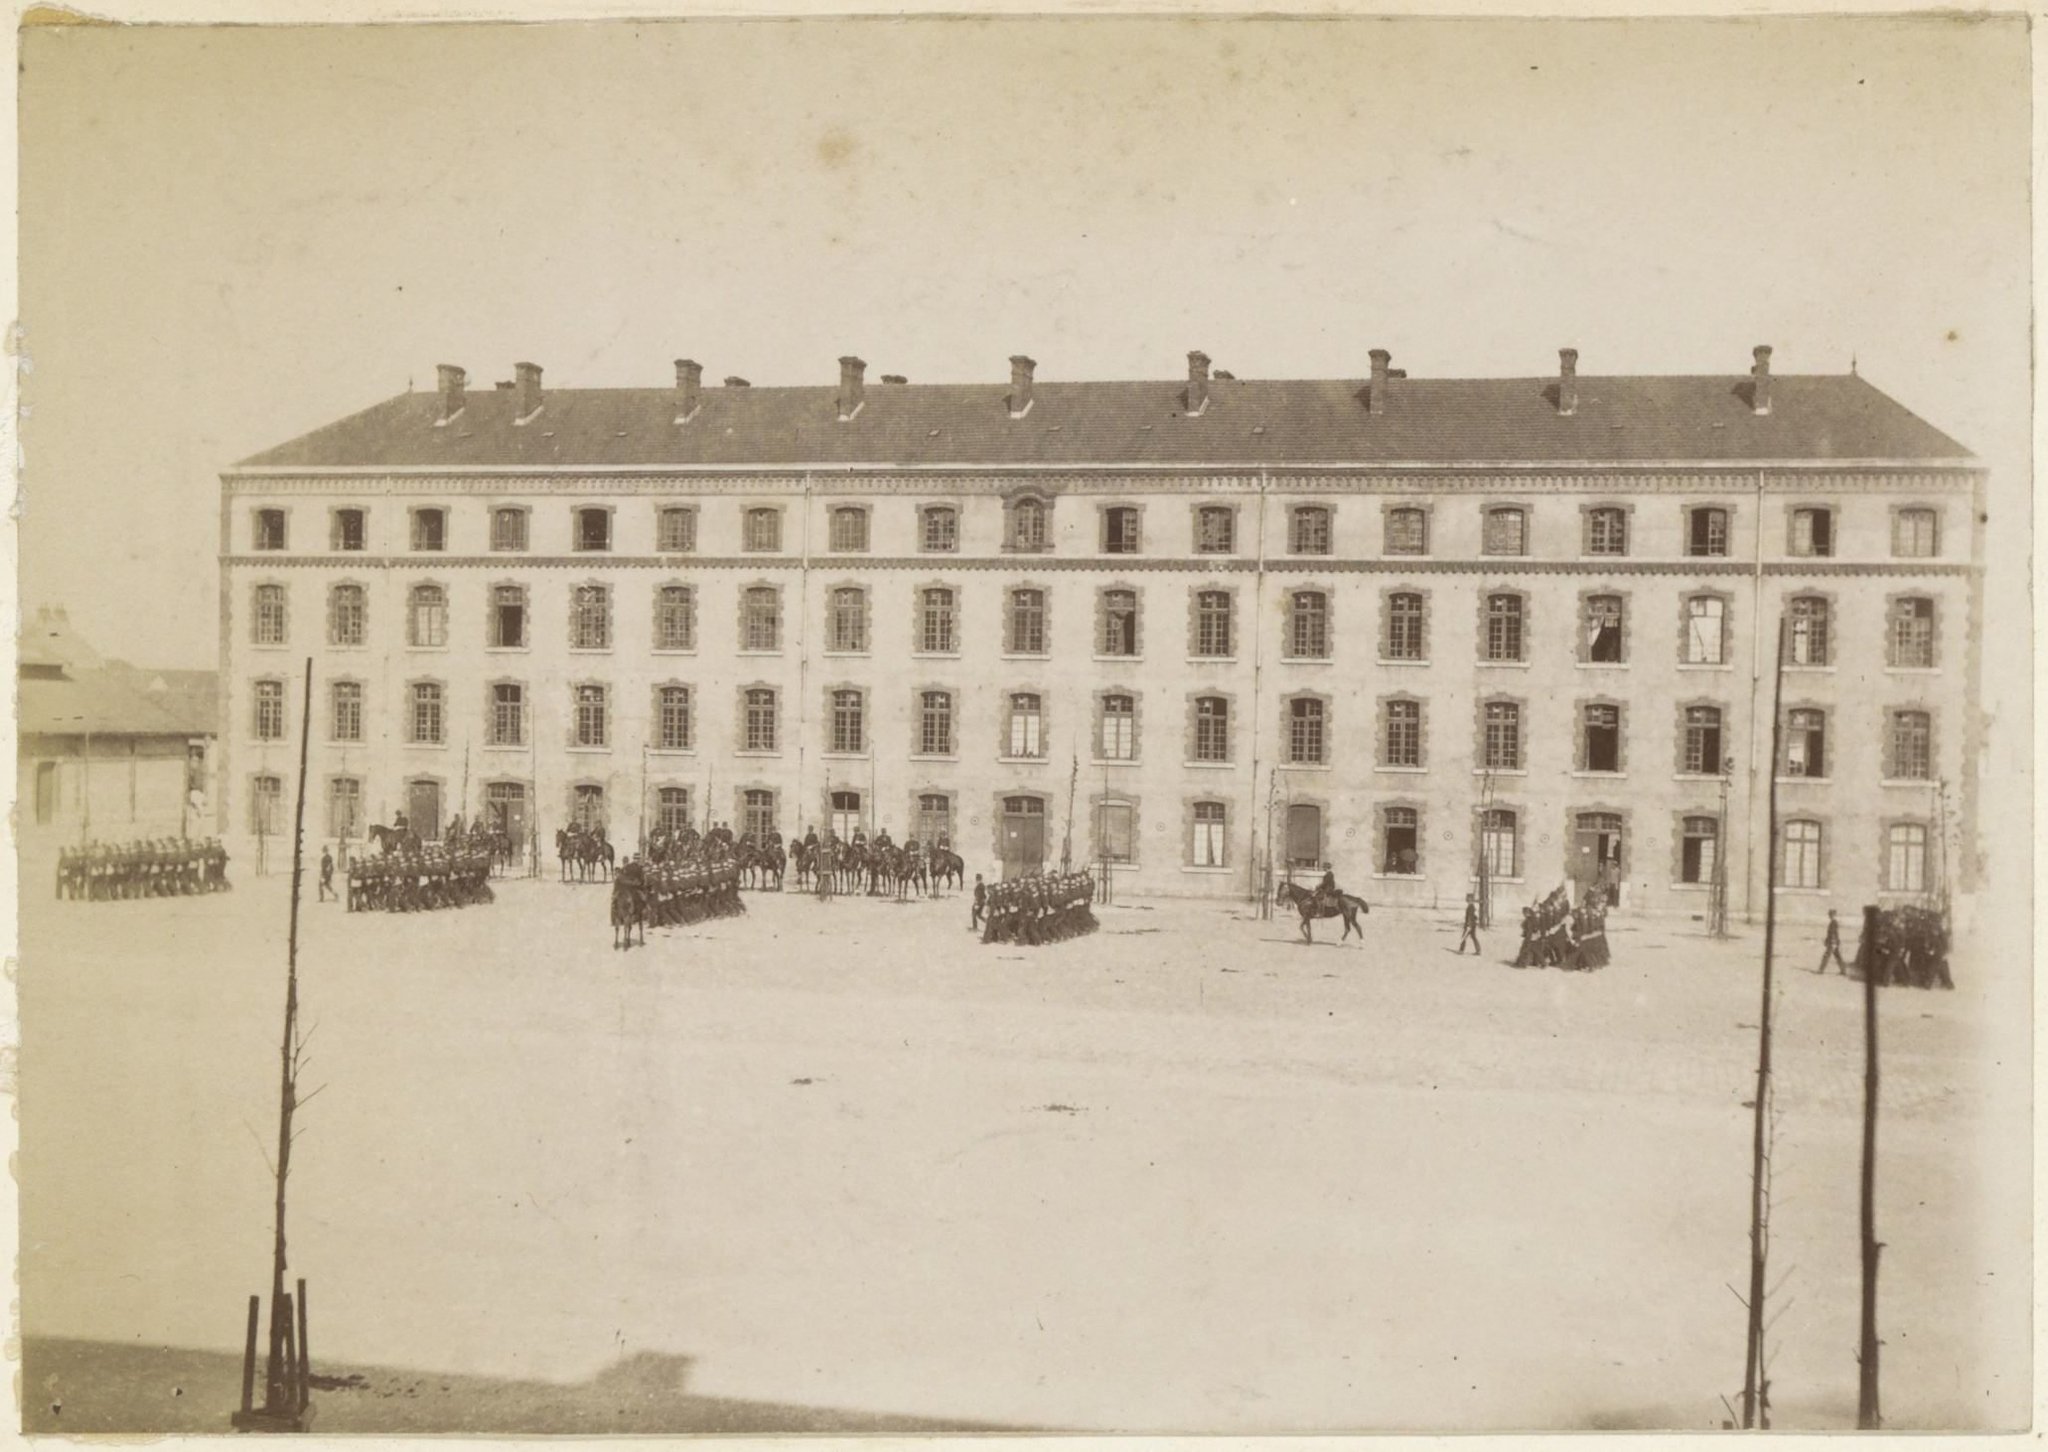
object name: photograph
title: Kazerne met marcherende soldaten ervoor in Frankrijk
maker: Anonymous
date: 1900-1910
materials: paper, photographic support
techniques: albumen print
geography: france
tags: marching away (troops), barracks (+ land forces), land forces, france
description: Onderdeel van Fotoalbum van een Franse amateurfotograaf met opnames van een familie, distilleerderij Delizy & Doistau Fils, het leger en bezienswaardigheden in Frankrijk.